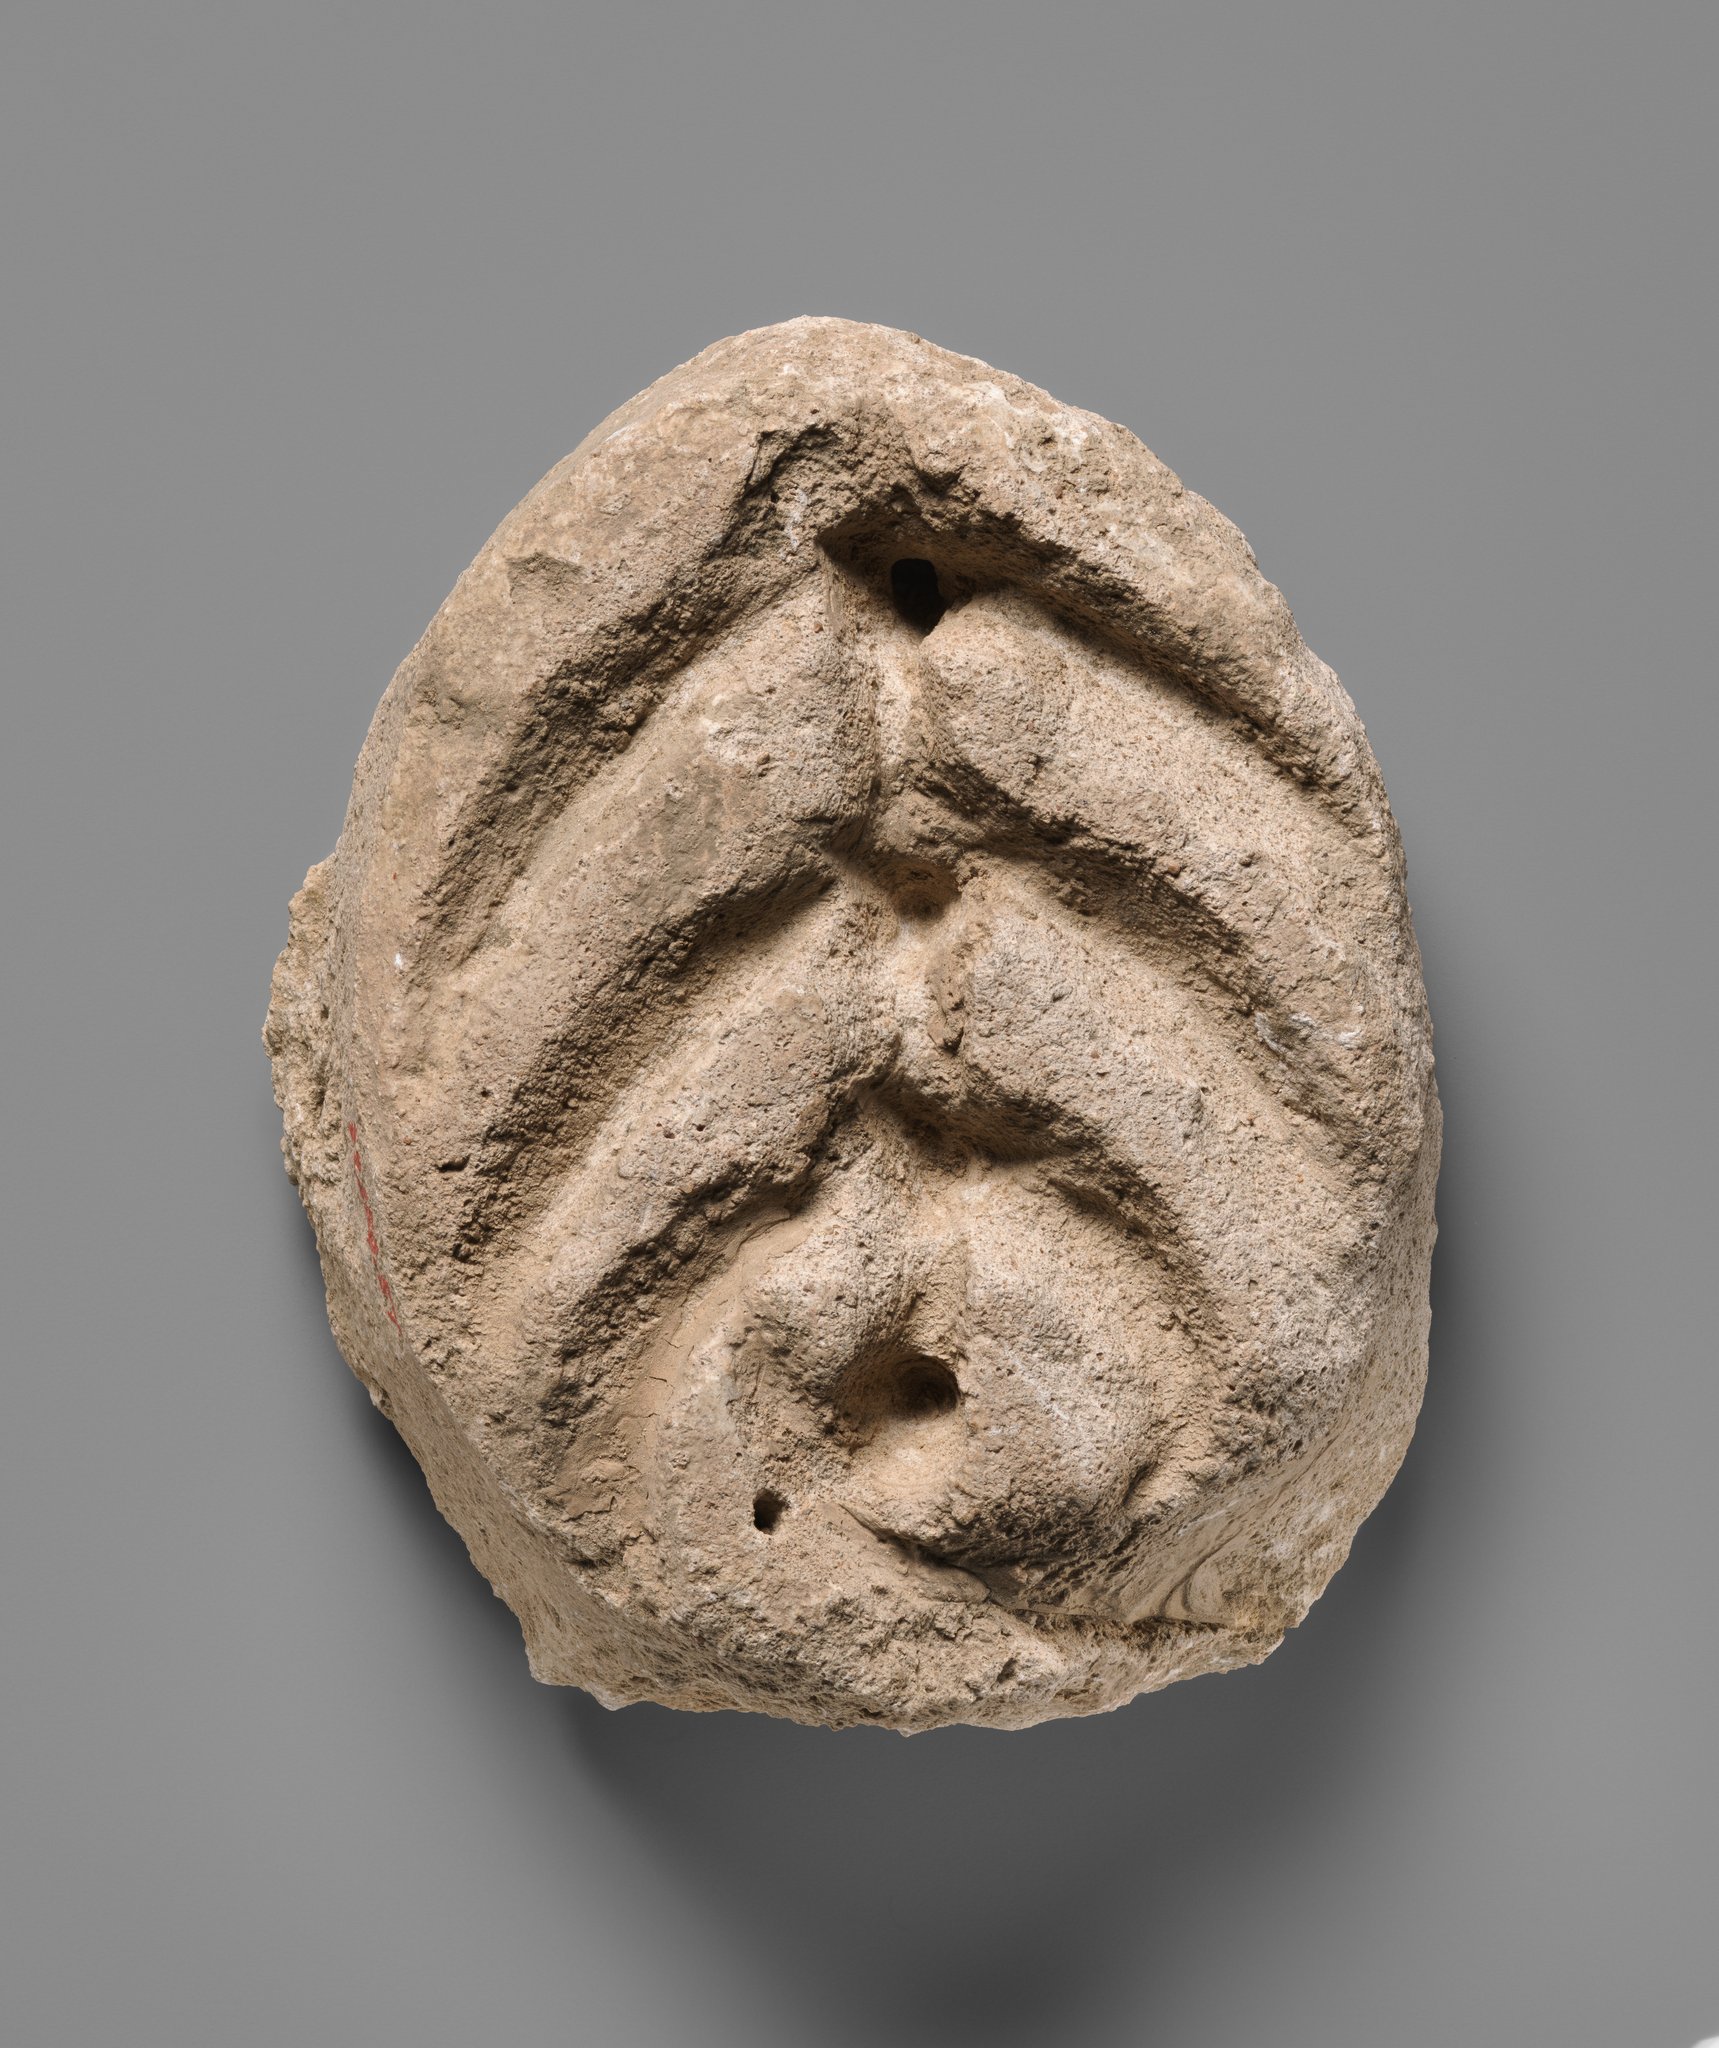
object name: relief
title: Relief fragment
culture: sasanian or islamic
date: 501-800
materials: plaster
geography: mesopotamia